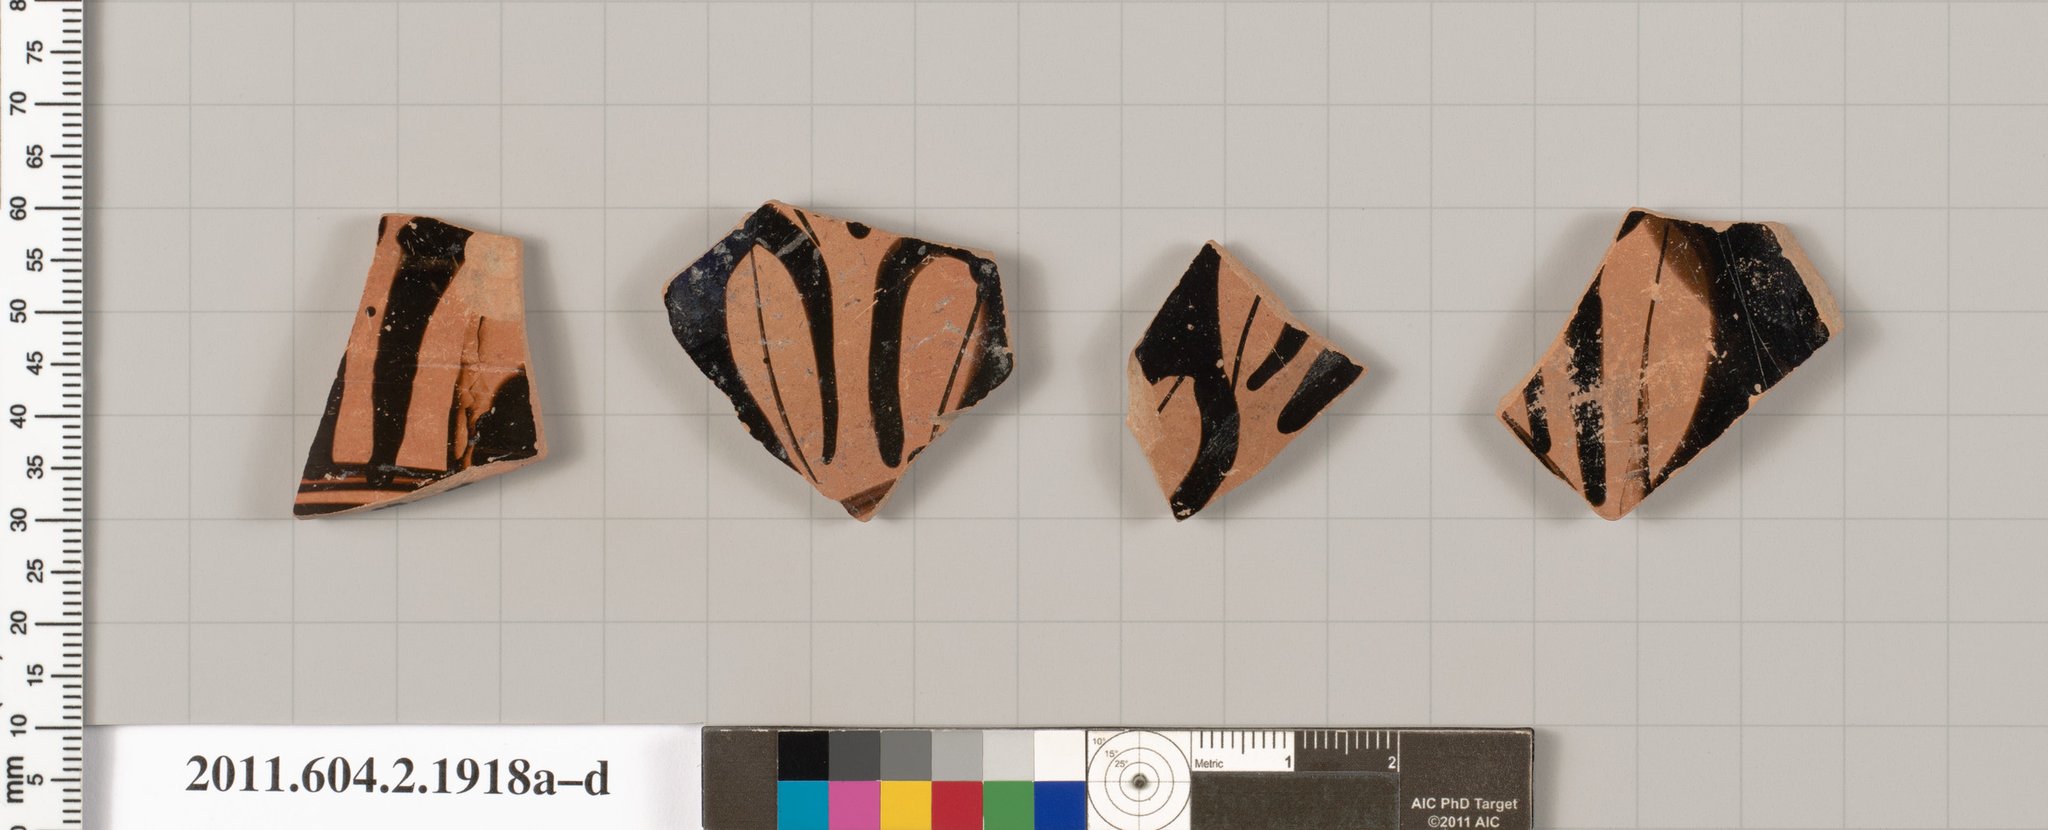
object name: skyphos fragment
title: Terracotta fragments of skyphoi (deep drinking cups)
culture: greek, attic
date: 460-430 BCE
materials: terracotta